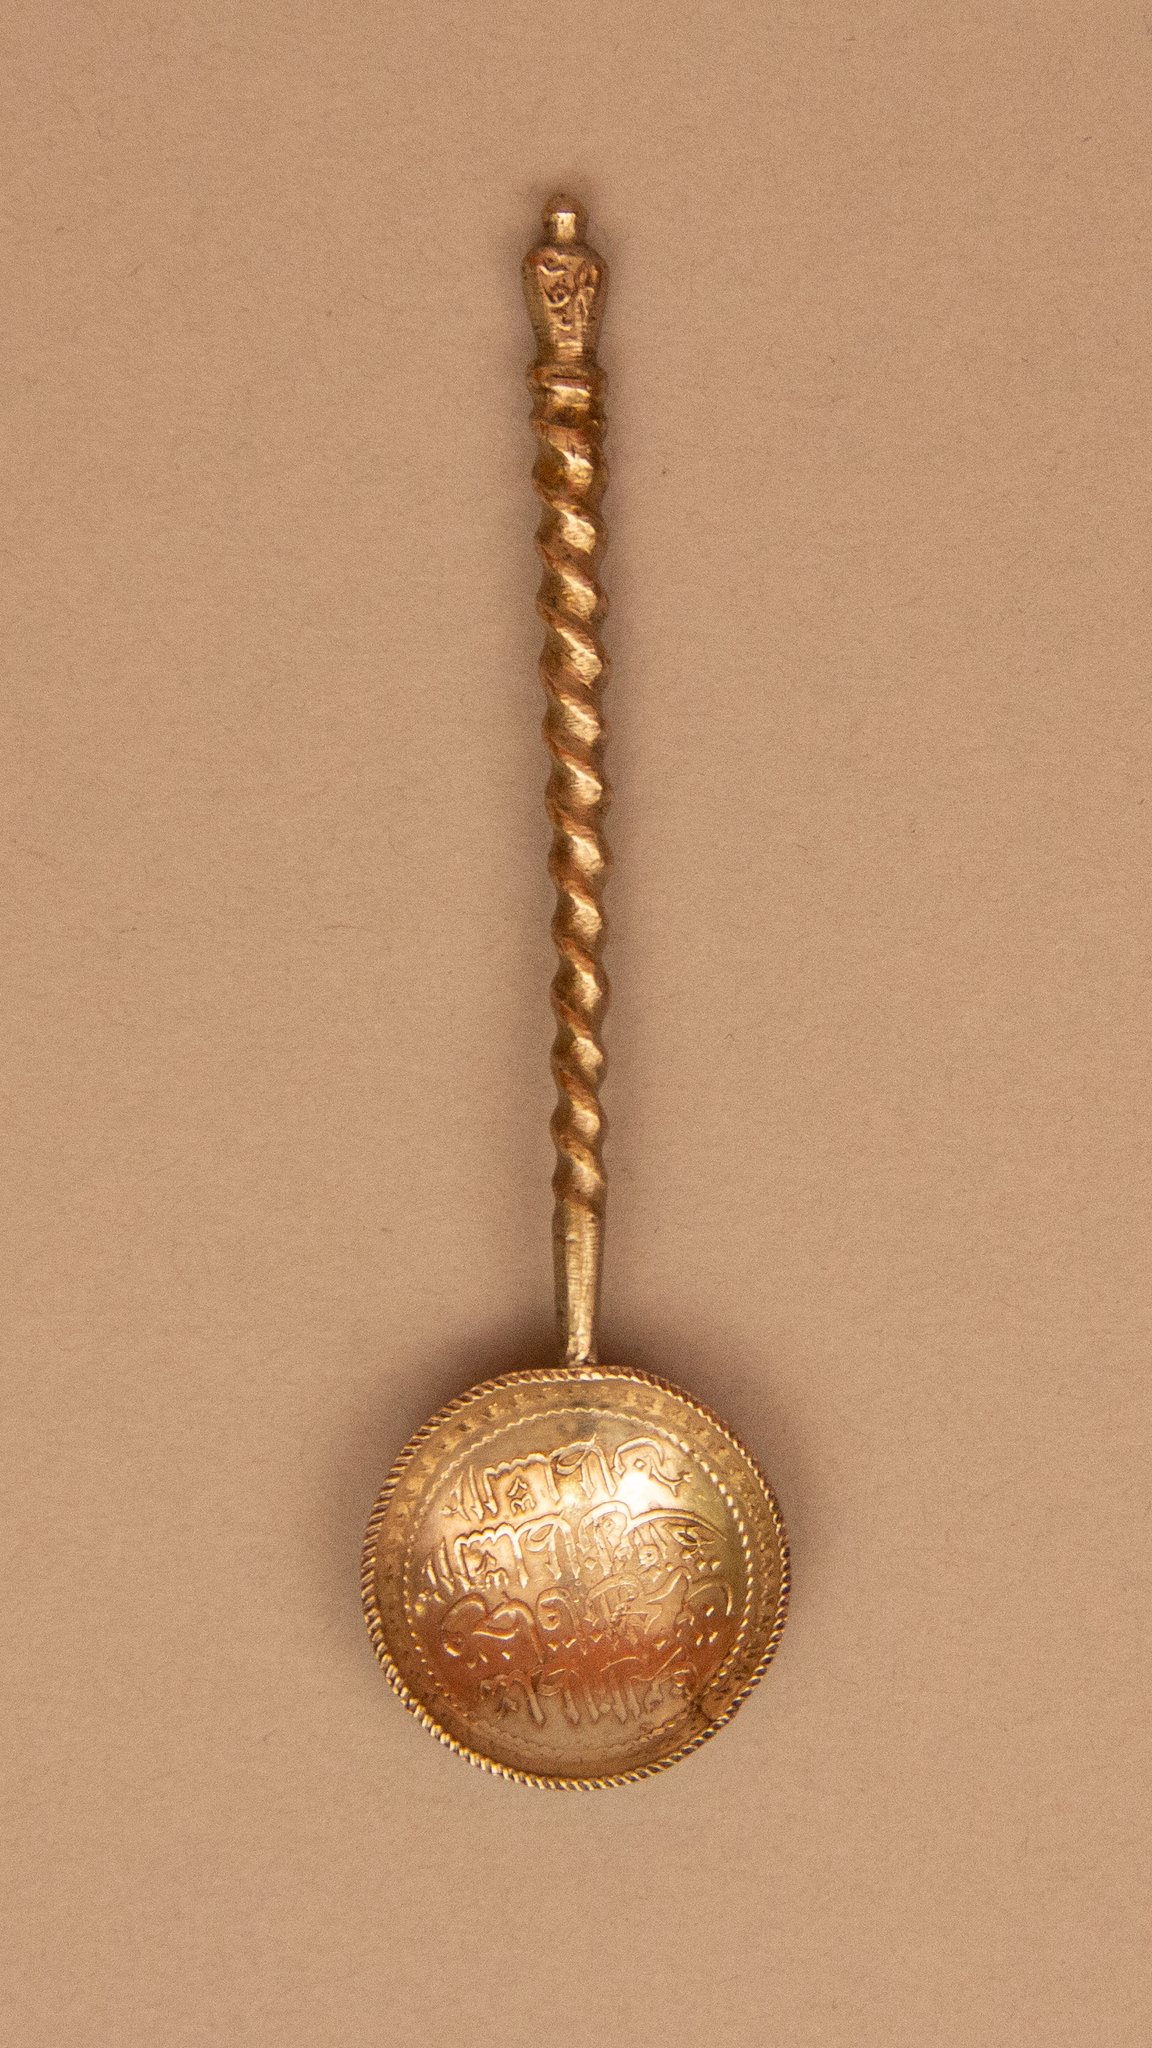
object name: spoon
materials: gilt, silver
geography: turkey